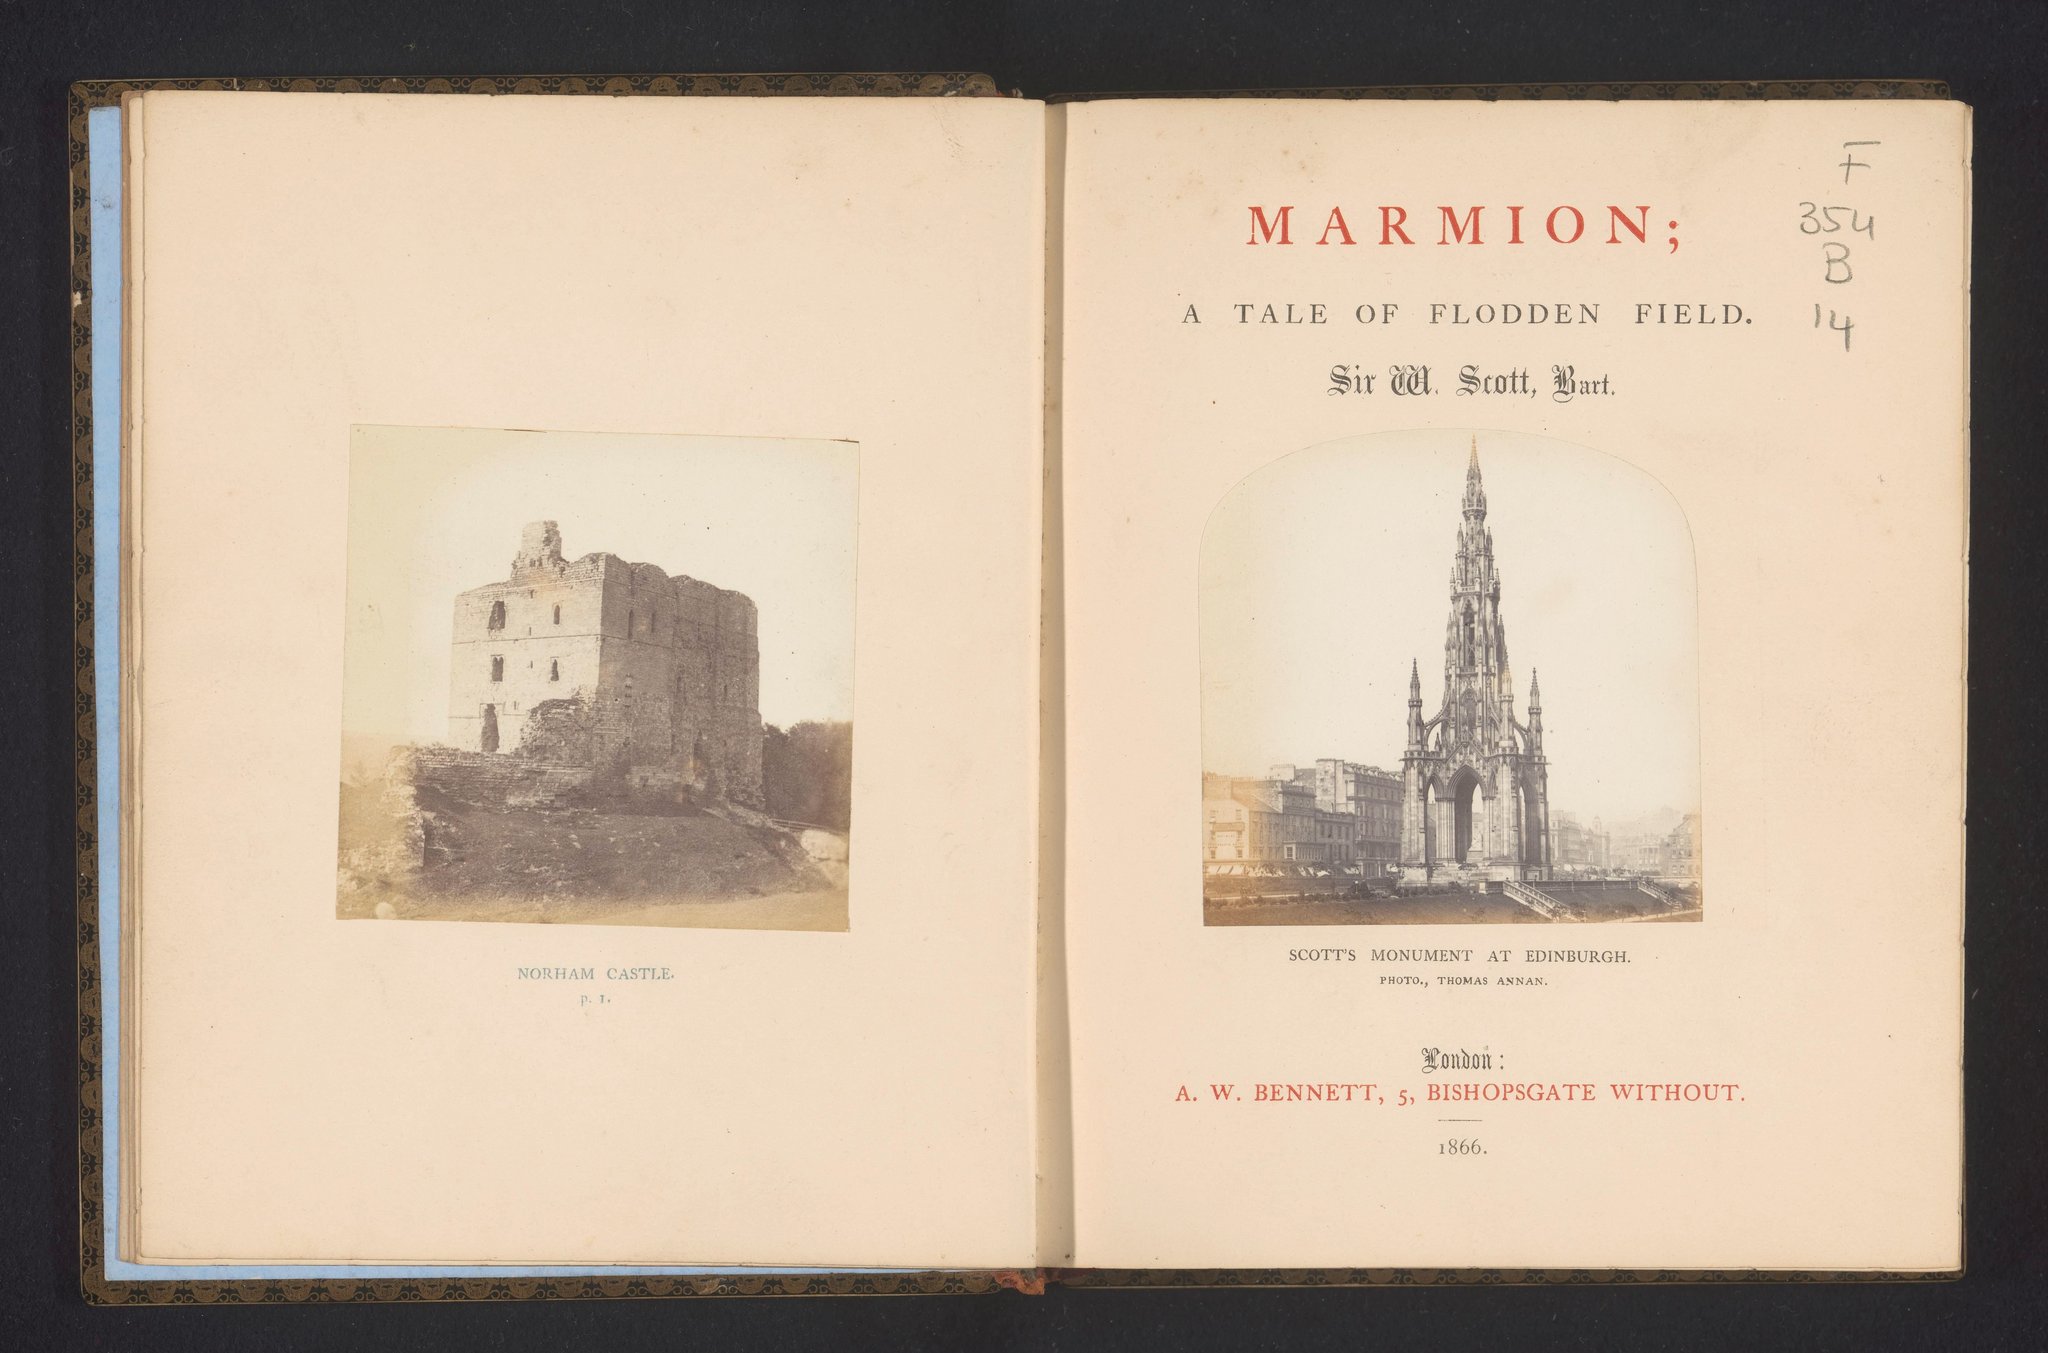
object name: book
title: Marmion; a tale of Flodden Field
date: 1866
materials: paper, photographic support, wood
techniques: albumen print, metalworking, engraving, printing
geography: london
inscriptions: inscription: ‘E.A. Dukes from M. W Arkens of Vall[...]burn Jan 1867.’